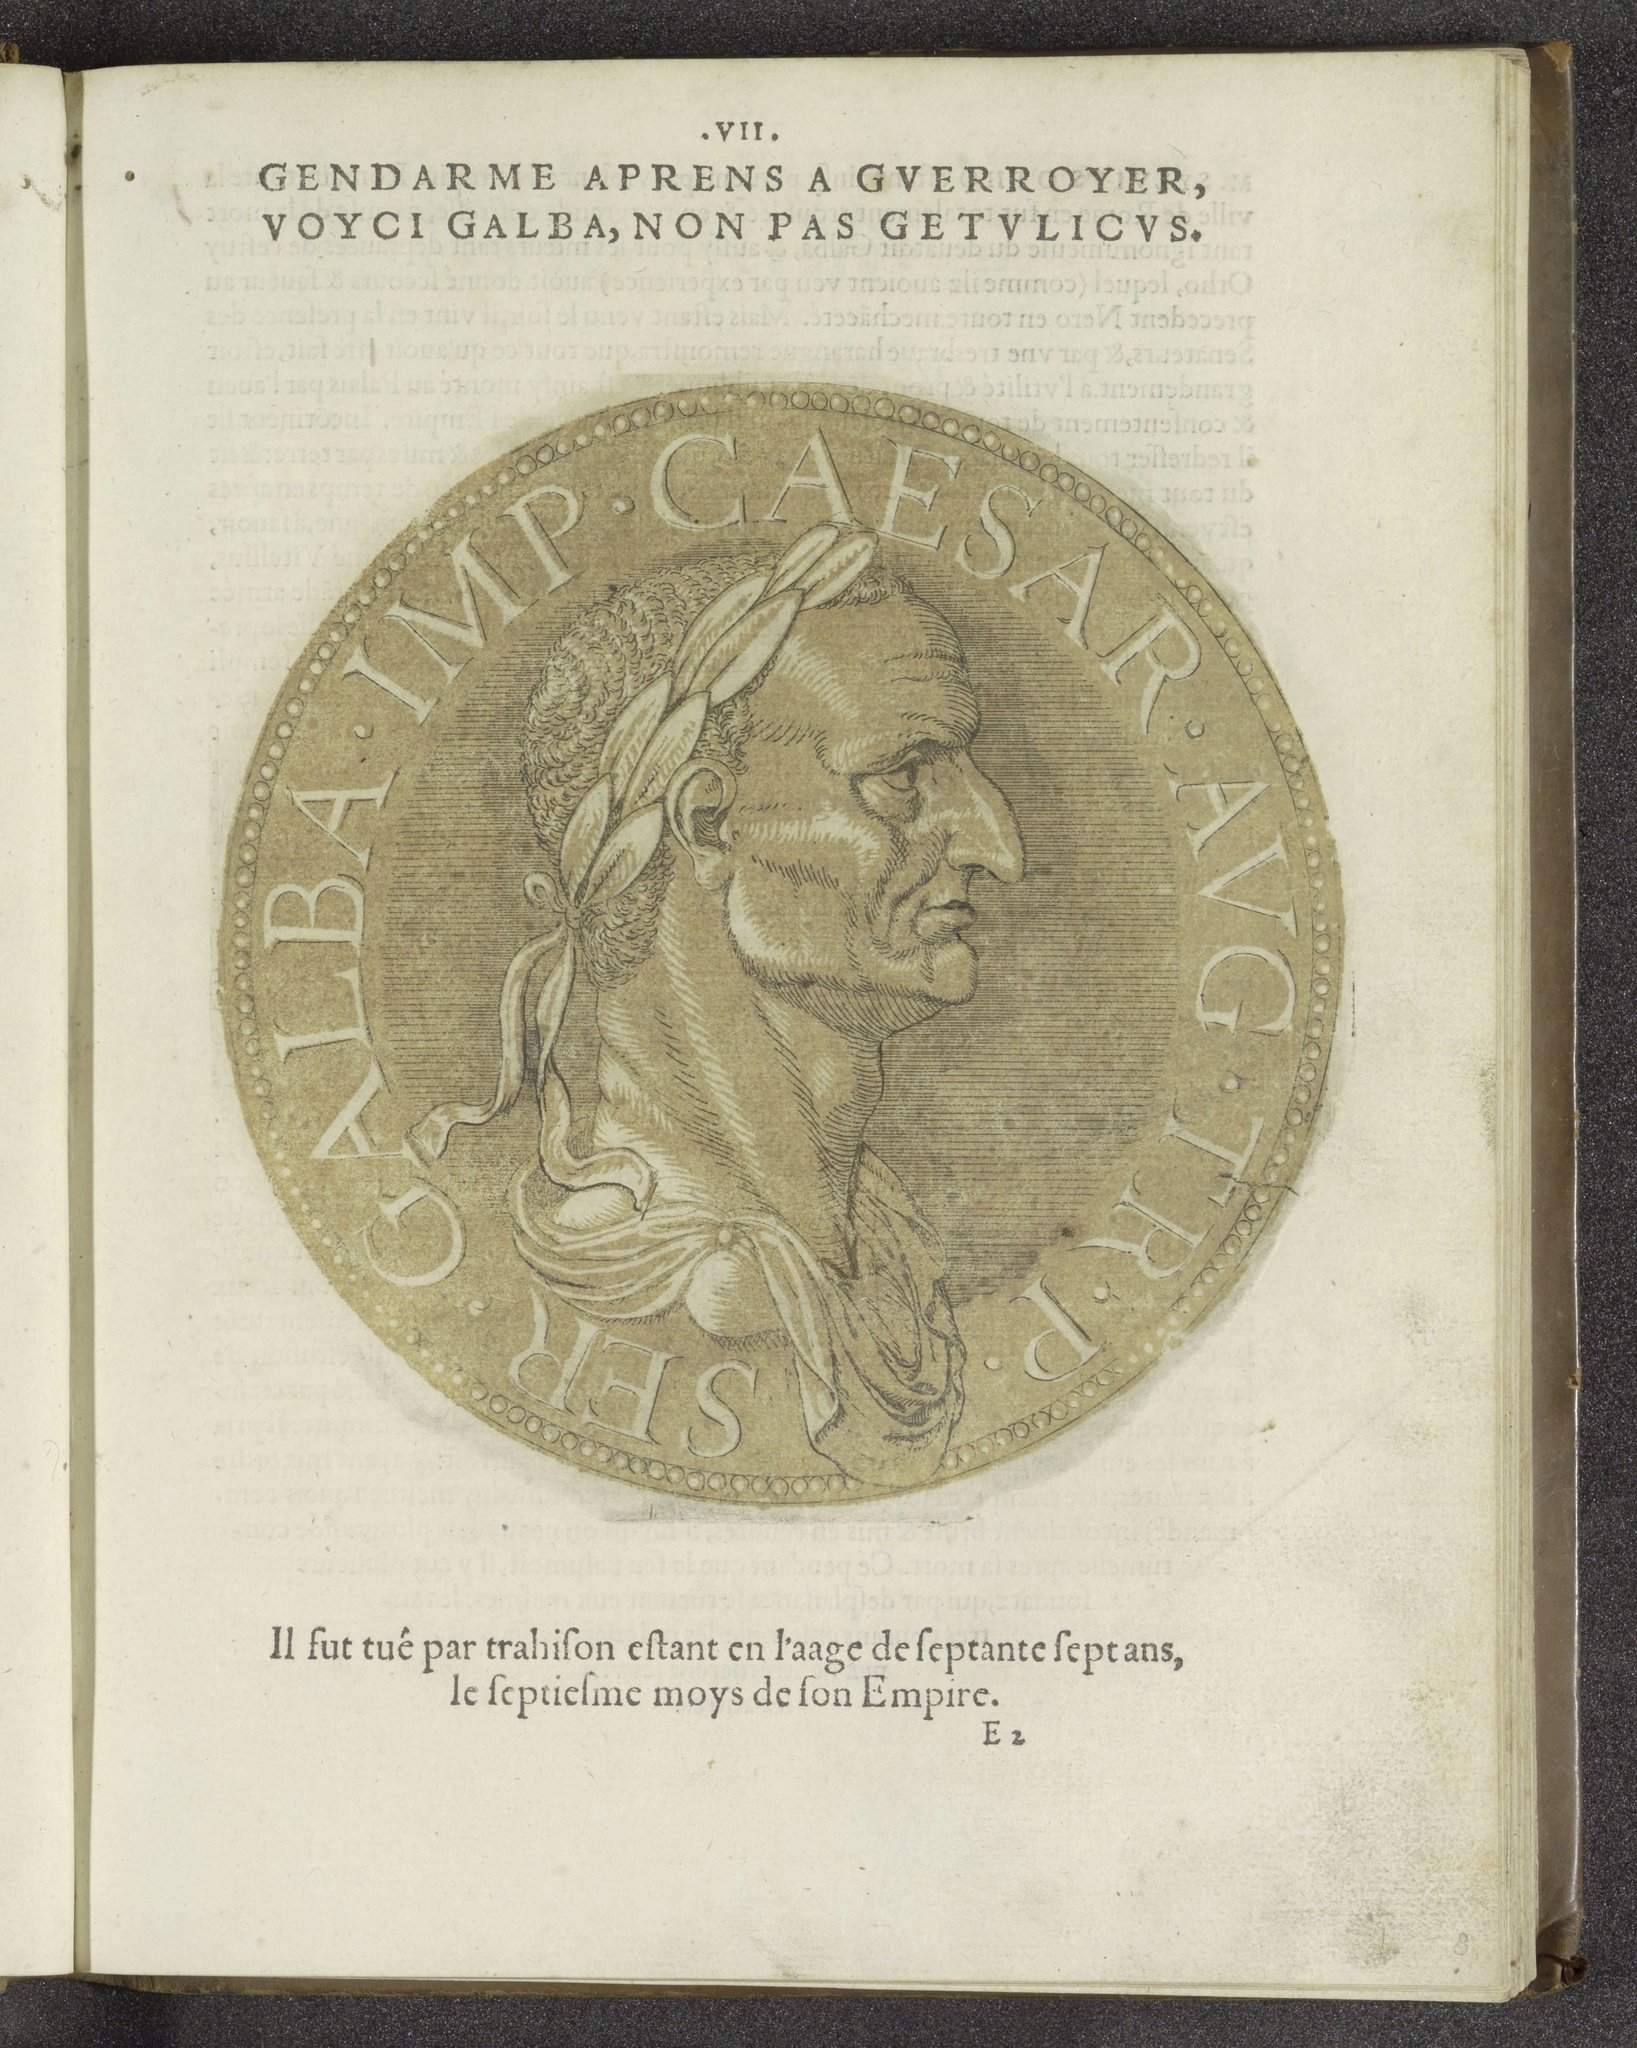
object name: print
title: Les images presque de tous les empereurs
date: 1557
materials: paper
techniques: woodcut, etching, letterpress printing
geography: antwerp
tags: emperor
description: Portret van keizer Alba, op een munt met randschrift. De prent maakt deel uit van een boek over de keizers vanaf Julius Caesar tot en met Karel V en zijn broer Ferdinand.